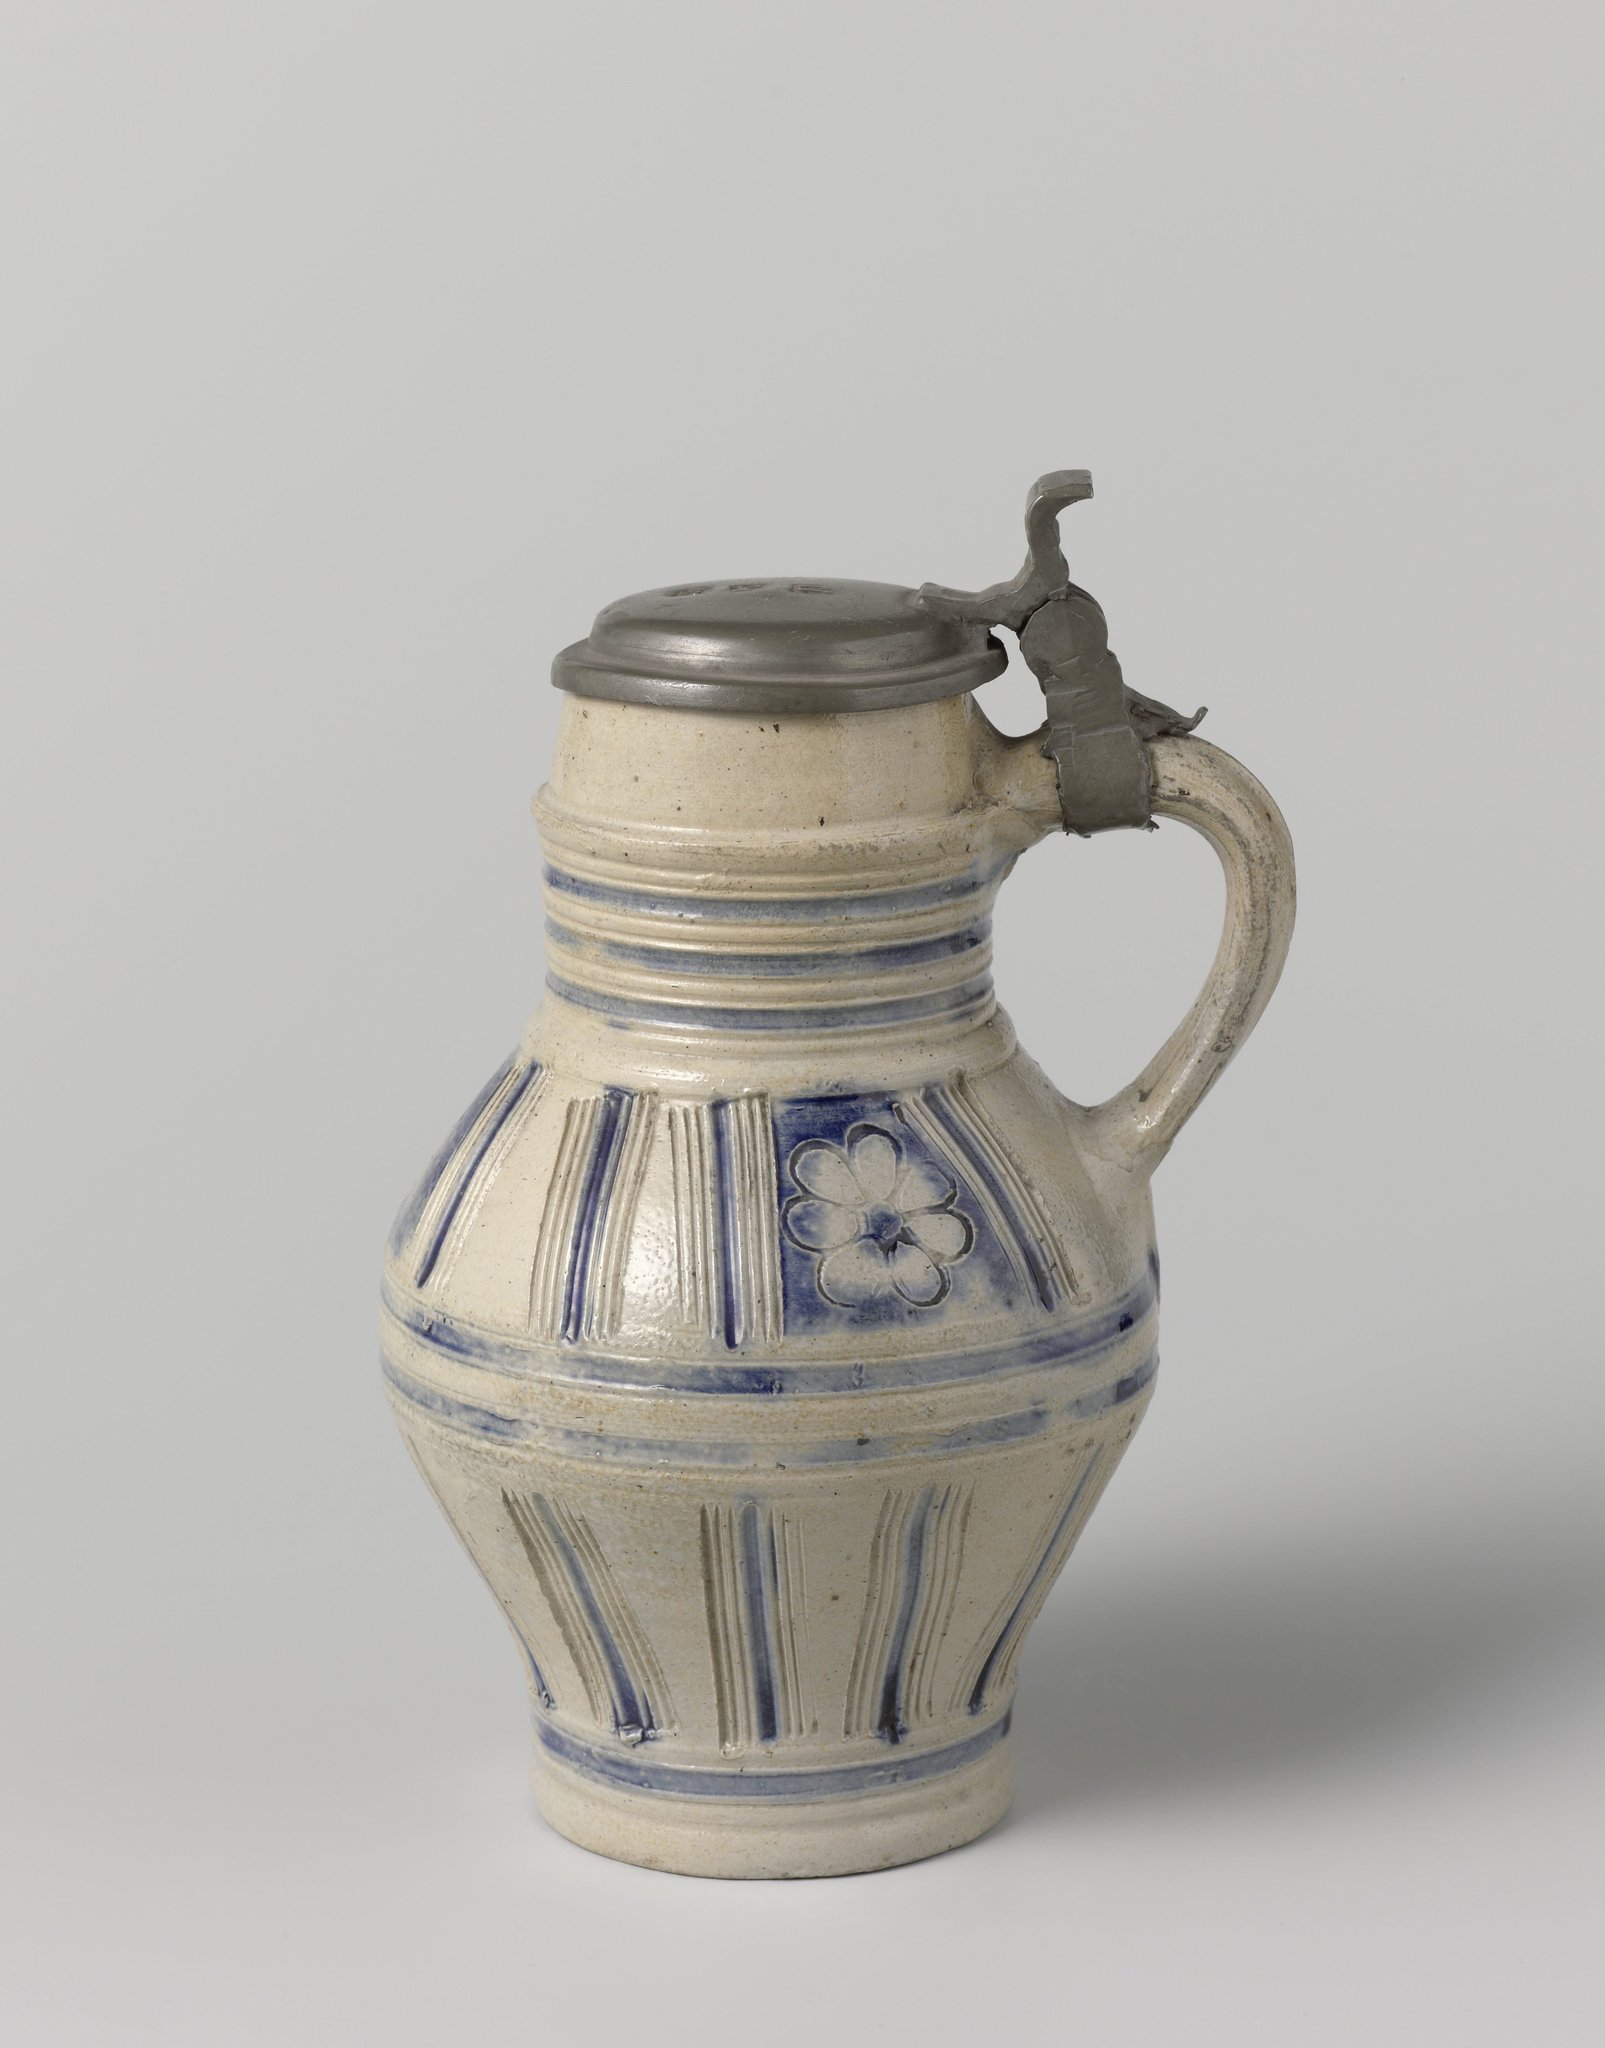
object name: jug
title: Jug with insiced borders and flower roundels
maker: Anonymous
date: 1630-1720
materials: cobalt, glaze, stoneware, tin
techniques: printing, firing, turning, vitrification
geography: westerwald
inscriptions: inscription: ‘12 10 11’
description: Kruik van steengoed op standring met een eivormige buik en een brede, korte nek. Het C-vormige oor is bevestigd aan de nek en de schouder. Gedecoreerd met kobaltblauw. Op de voet, buik en nek enkele profielen, waarvan de brede ingevuld zijn met blauw. Op de buik twee banden met een ingegrifte vakdecoratie. De bovenste band met gestempelde bloemrozetten tegen een blauwe achtergrond. Tinnen montuur met deksel bevestigd aan het oor met het opschrift '12 10 11'. Westerwald.